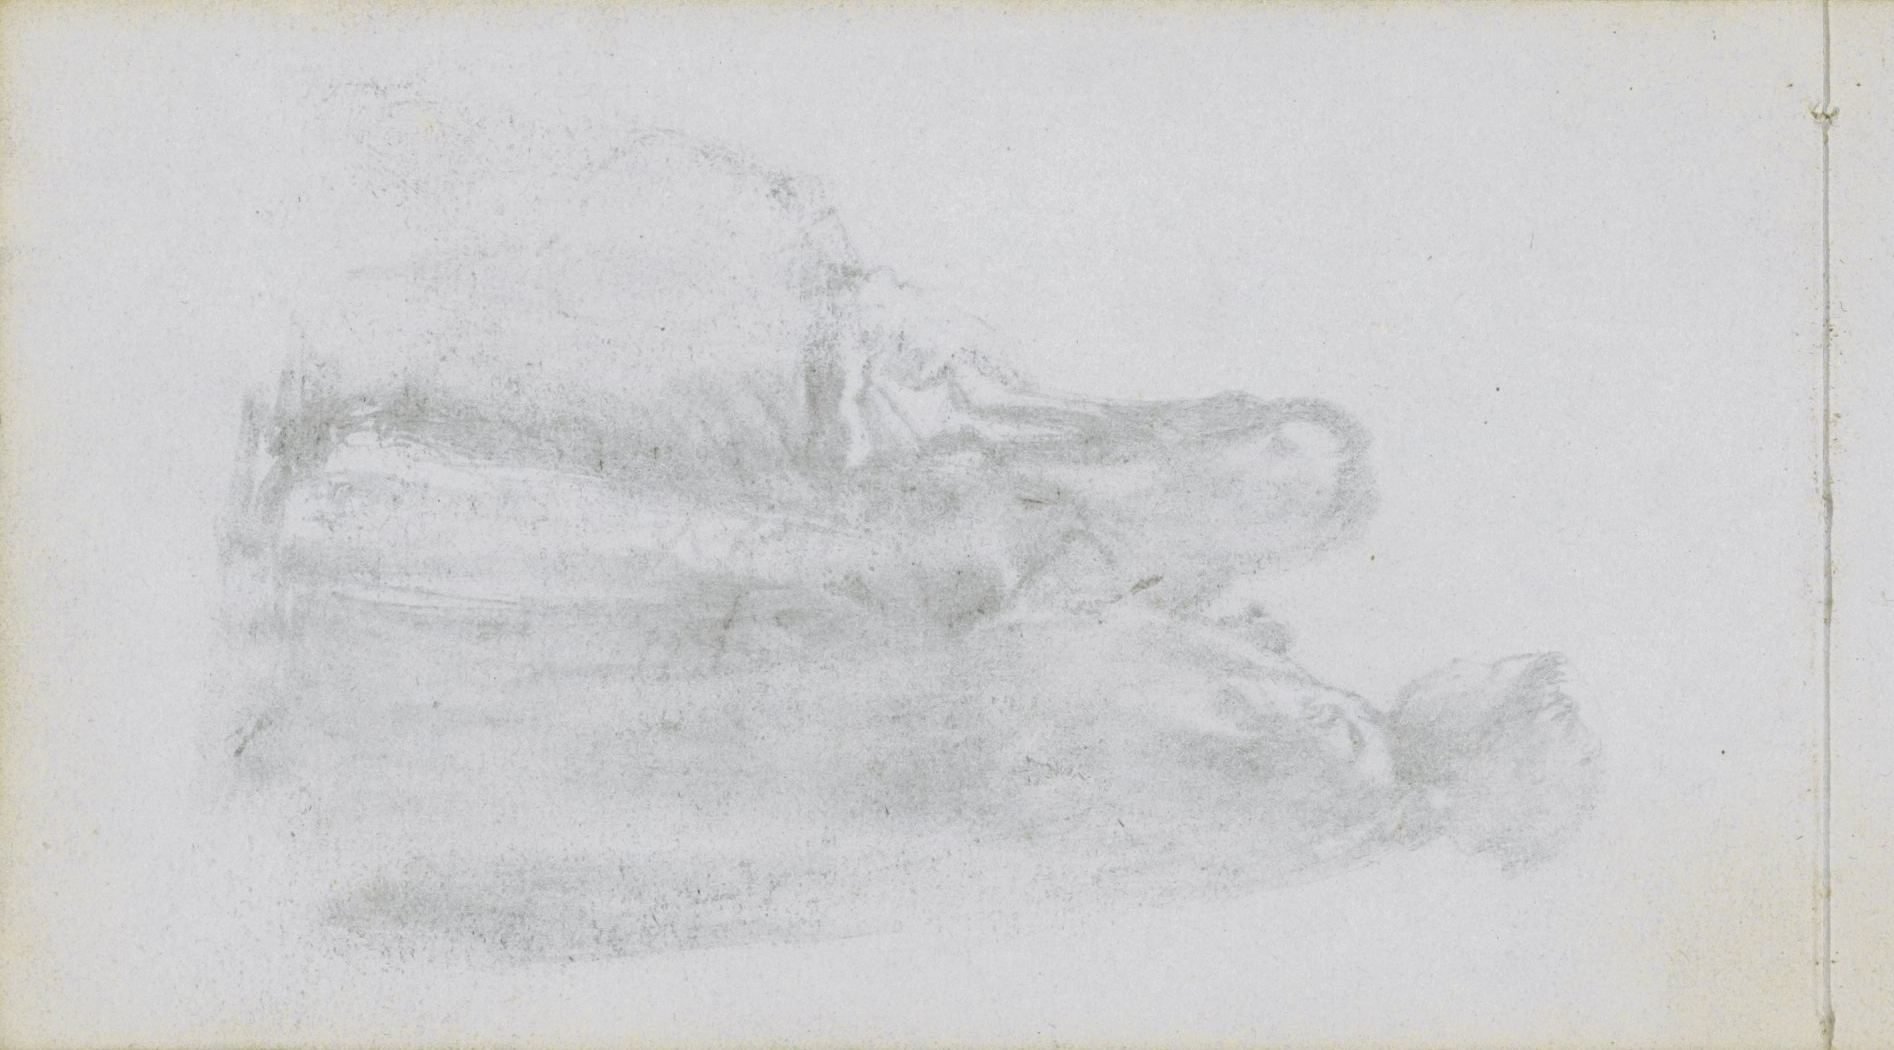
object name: sketchbook leaf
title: Abklatsch van de tekening op pagina 13 recto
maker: johan hendrik weissenbruch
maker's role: draughtsman, painter, print maker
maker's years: 1824-1903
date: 1834-1903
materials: paper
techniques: printmaking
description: Blad 12 verso uit een schetsboek met 39 bladen.